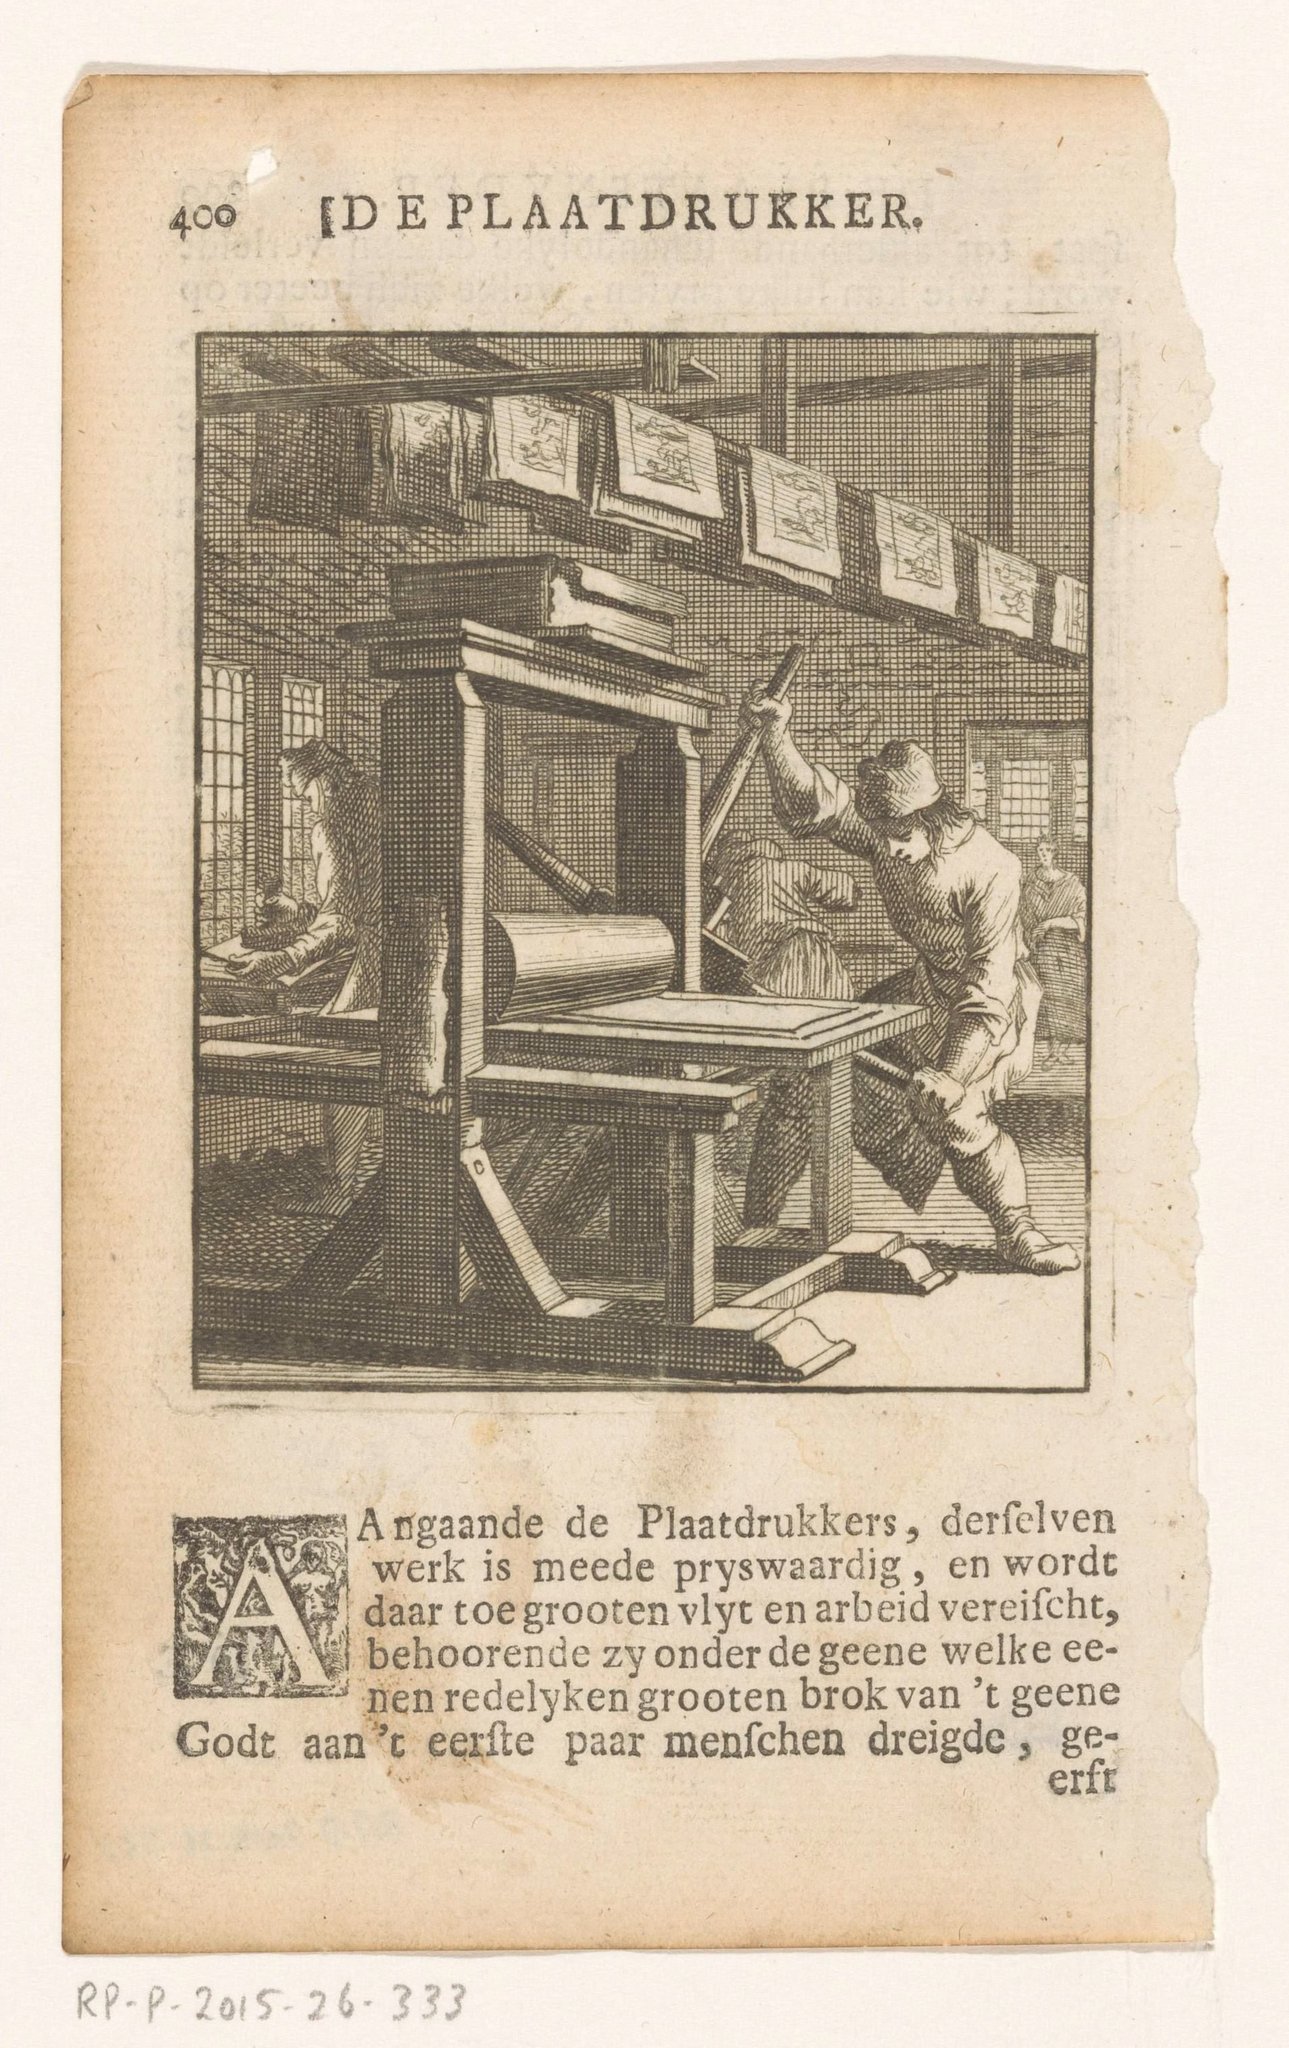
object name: print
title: De plaatdrukker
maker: Anonymous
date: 1736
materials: paper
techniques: etching, letterpress printing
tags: handicrafts, craftsman at work, printing press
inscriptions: collector's mark: Lugt 4780, collector's mark: Lugt 2228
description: Interieur van een drukkerij met een drukker die een koperplaat door een drukpers haalt. Aan het plafond hangen prenten te drogen. Linksboven genummerd: 400.